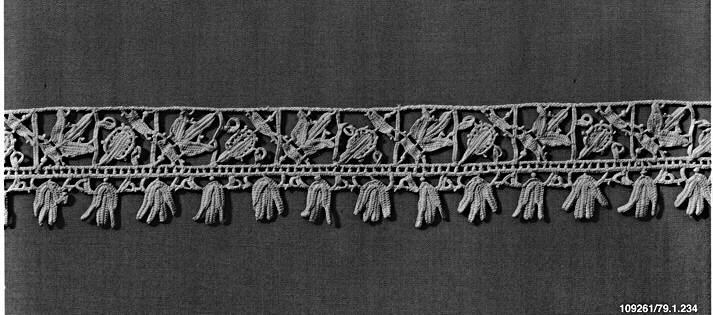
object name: edging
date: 1600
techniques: lace